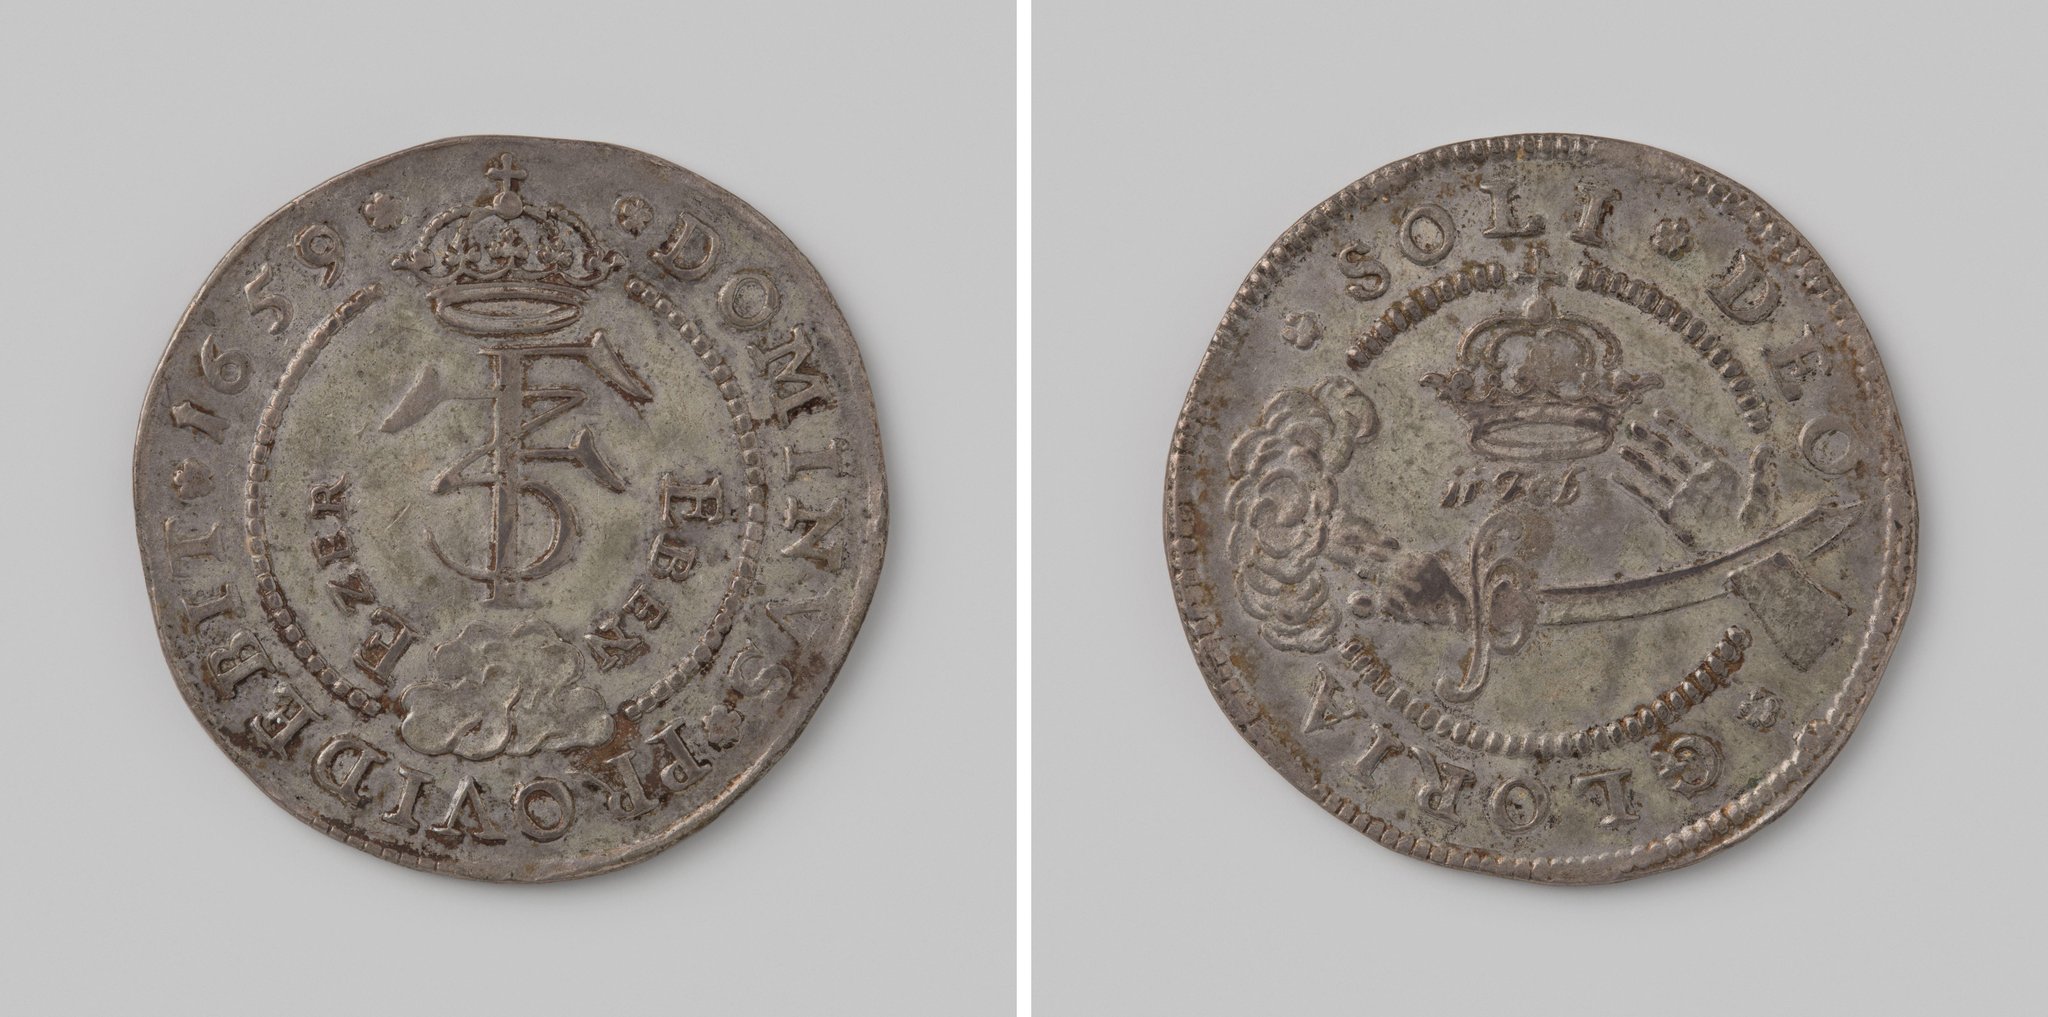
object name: coin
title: Denemarken, Frederik III, 4 mark danske, 1659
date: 1659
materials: silver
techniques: striking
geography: copenhagen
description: Zilveren munt. Voorzijde: tussen aanduiding: Eben Ezer bergrug, waarop gekroond monogram van de koning. Jaartal bovenaan aan het eind van het omschrift. Keerzijde: hand uit wolk met zwaard doorsnijdt andere hand die naar kroon reikt. Onder kroon aanduiding: ii Feb. Gladde rand.